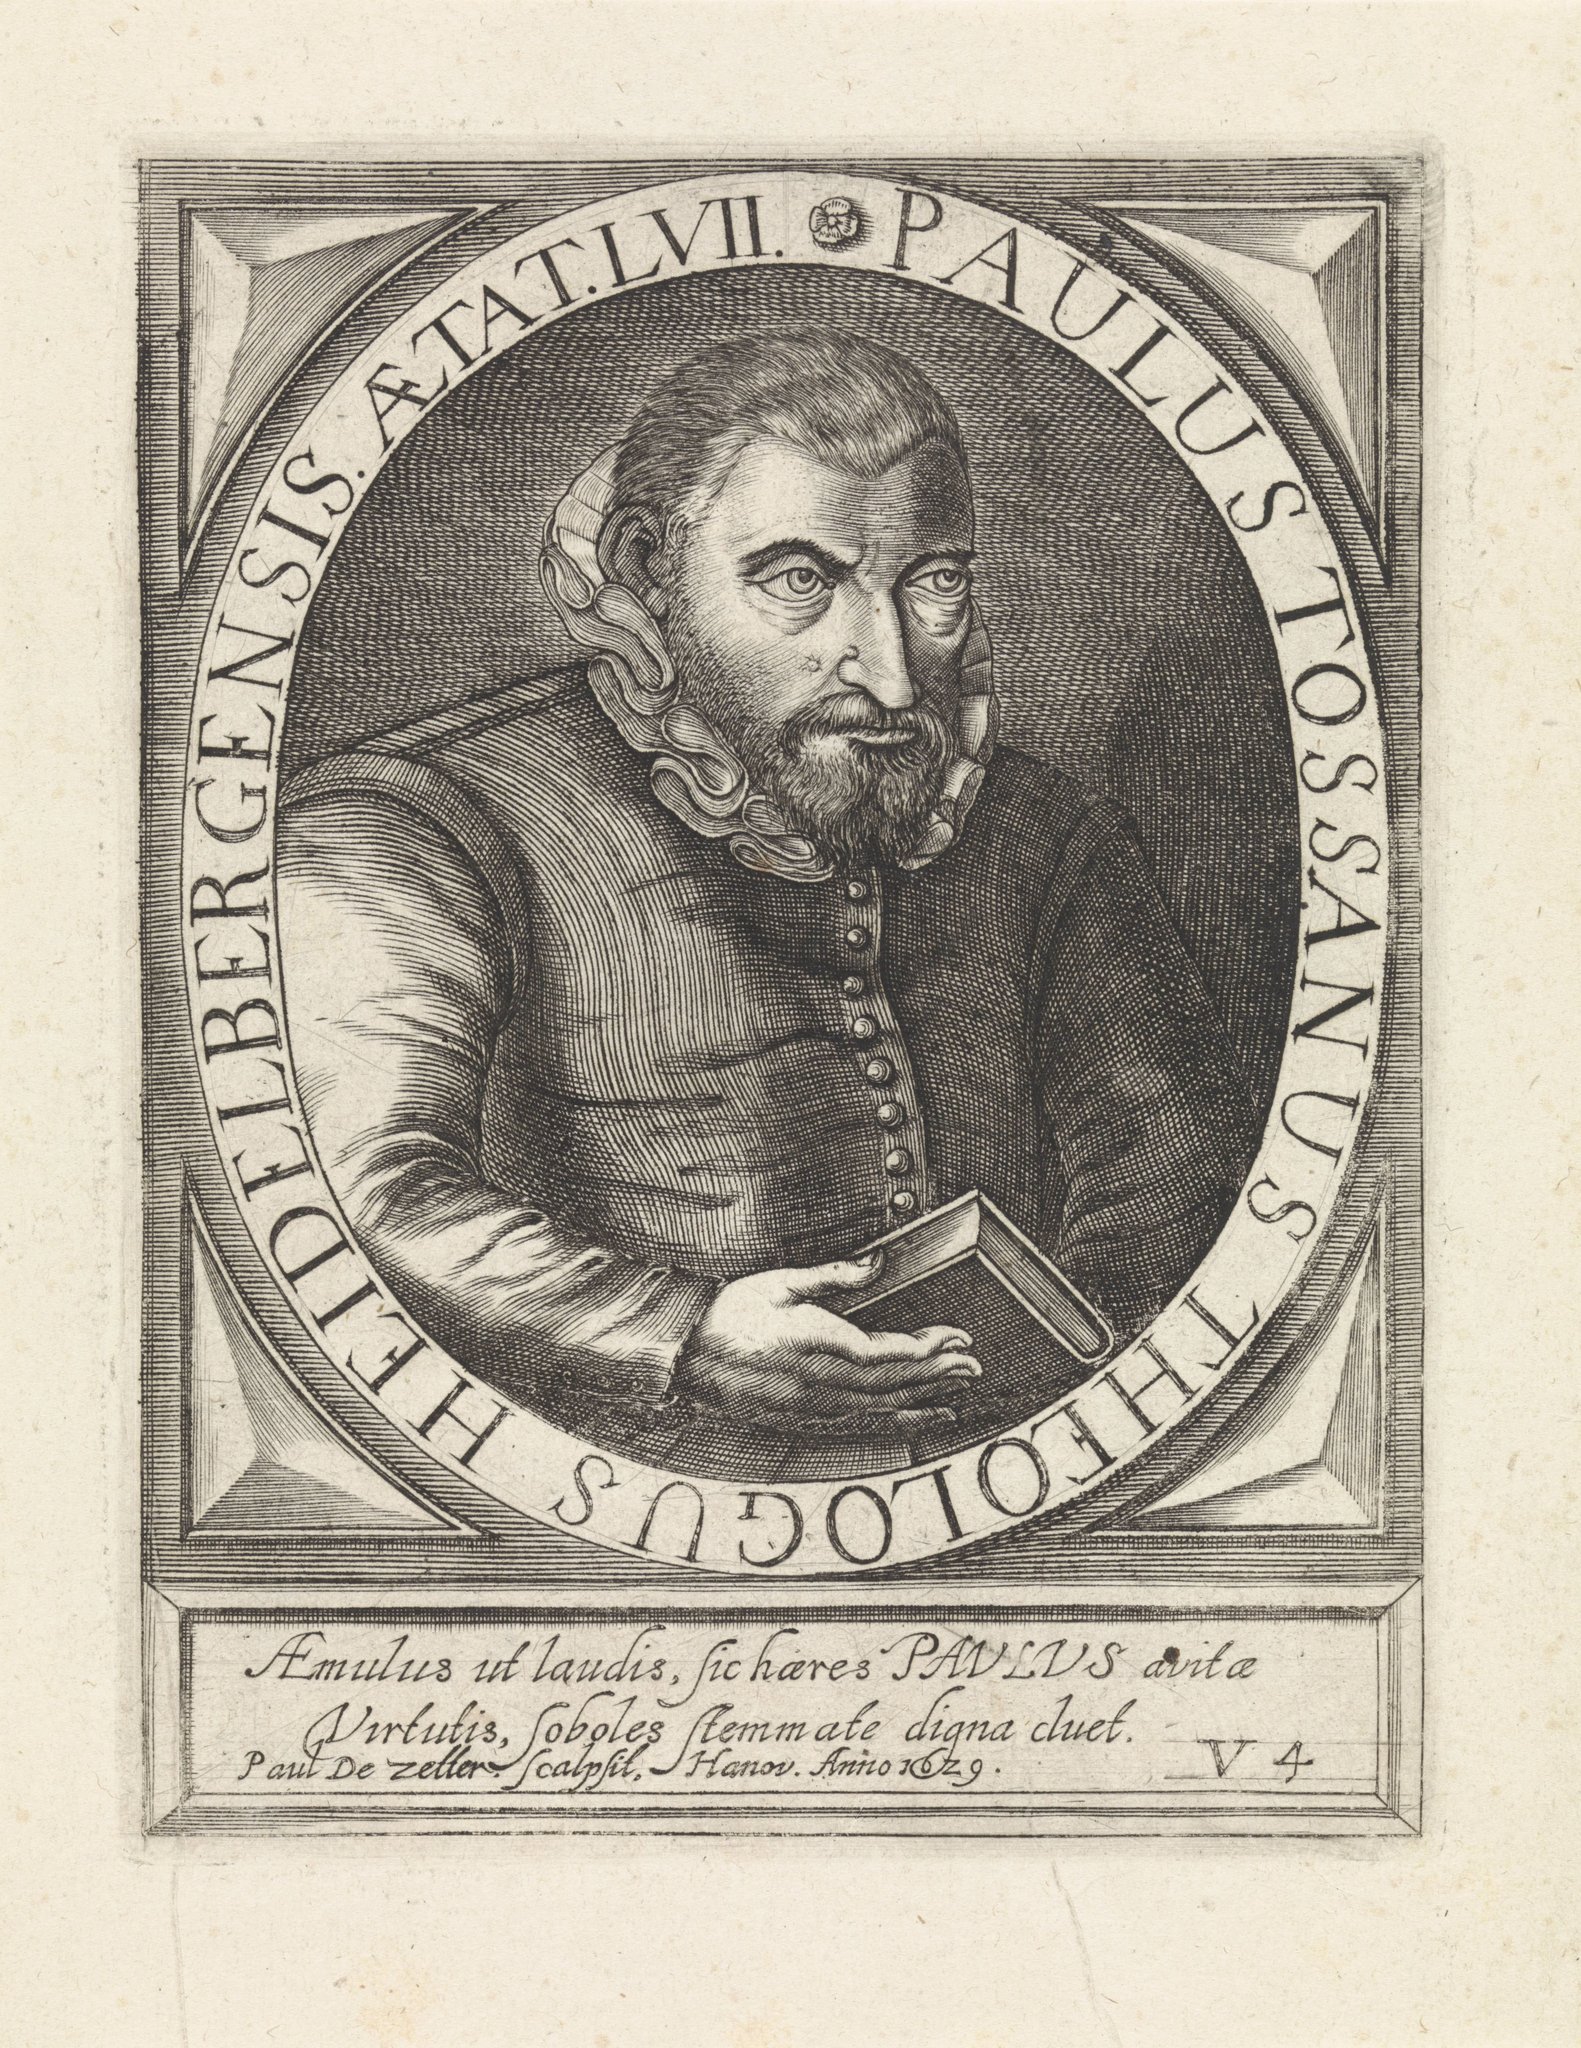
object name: book illustration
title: Portretten van beroemde Europese wetenschappers, humanisten en geestelijken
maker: paul de zetter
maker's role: print maker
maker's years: 1600-1667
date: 1629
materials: paper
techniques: engraving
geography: hannover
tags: montargis, heidelberg, theoloog, paul toussaint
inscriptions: collector's mark: Lugt 2228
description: Prent gebruikt in een van de edities van Jean-Jacques Boissard. Boissard, Jean-Jacques. Bibliotheca sive Thesaurus Virtutis et Gloriae: In quo continentus Illvstrivm Ervditione & doctrina Virorum Effigies & Vitae (...). Frankfurt, [1628]. Zie Hollstein Dutch, deel LVIII, p. 86-87.